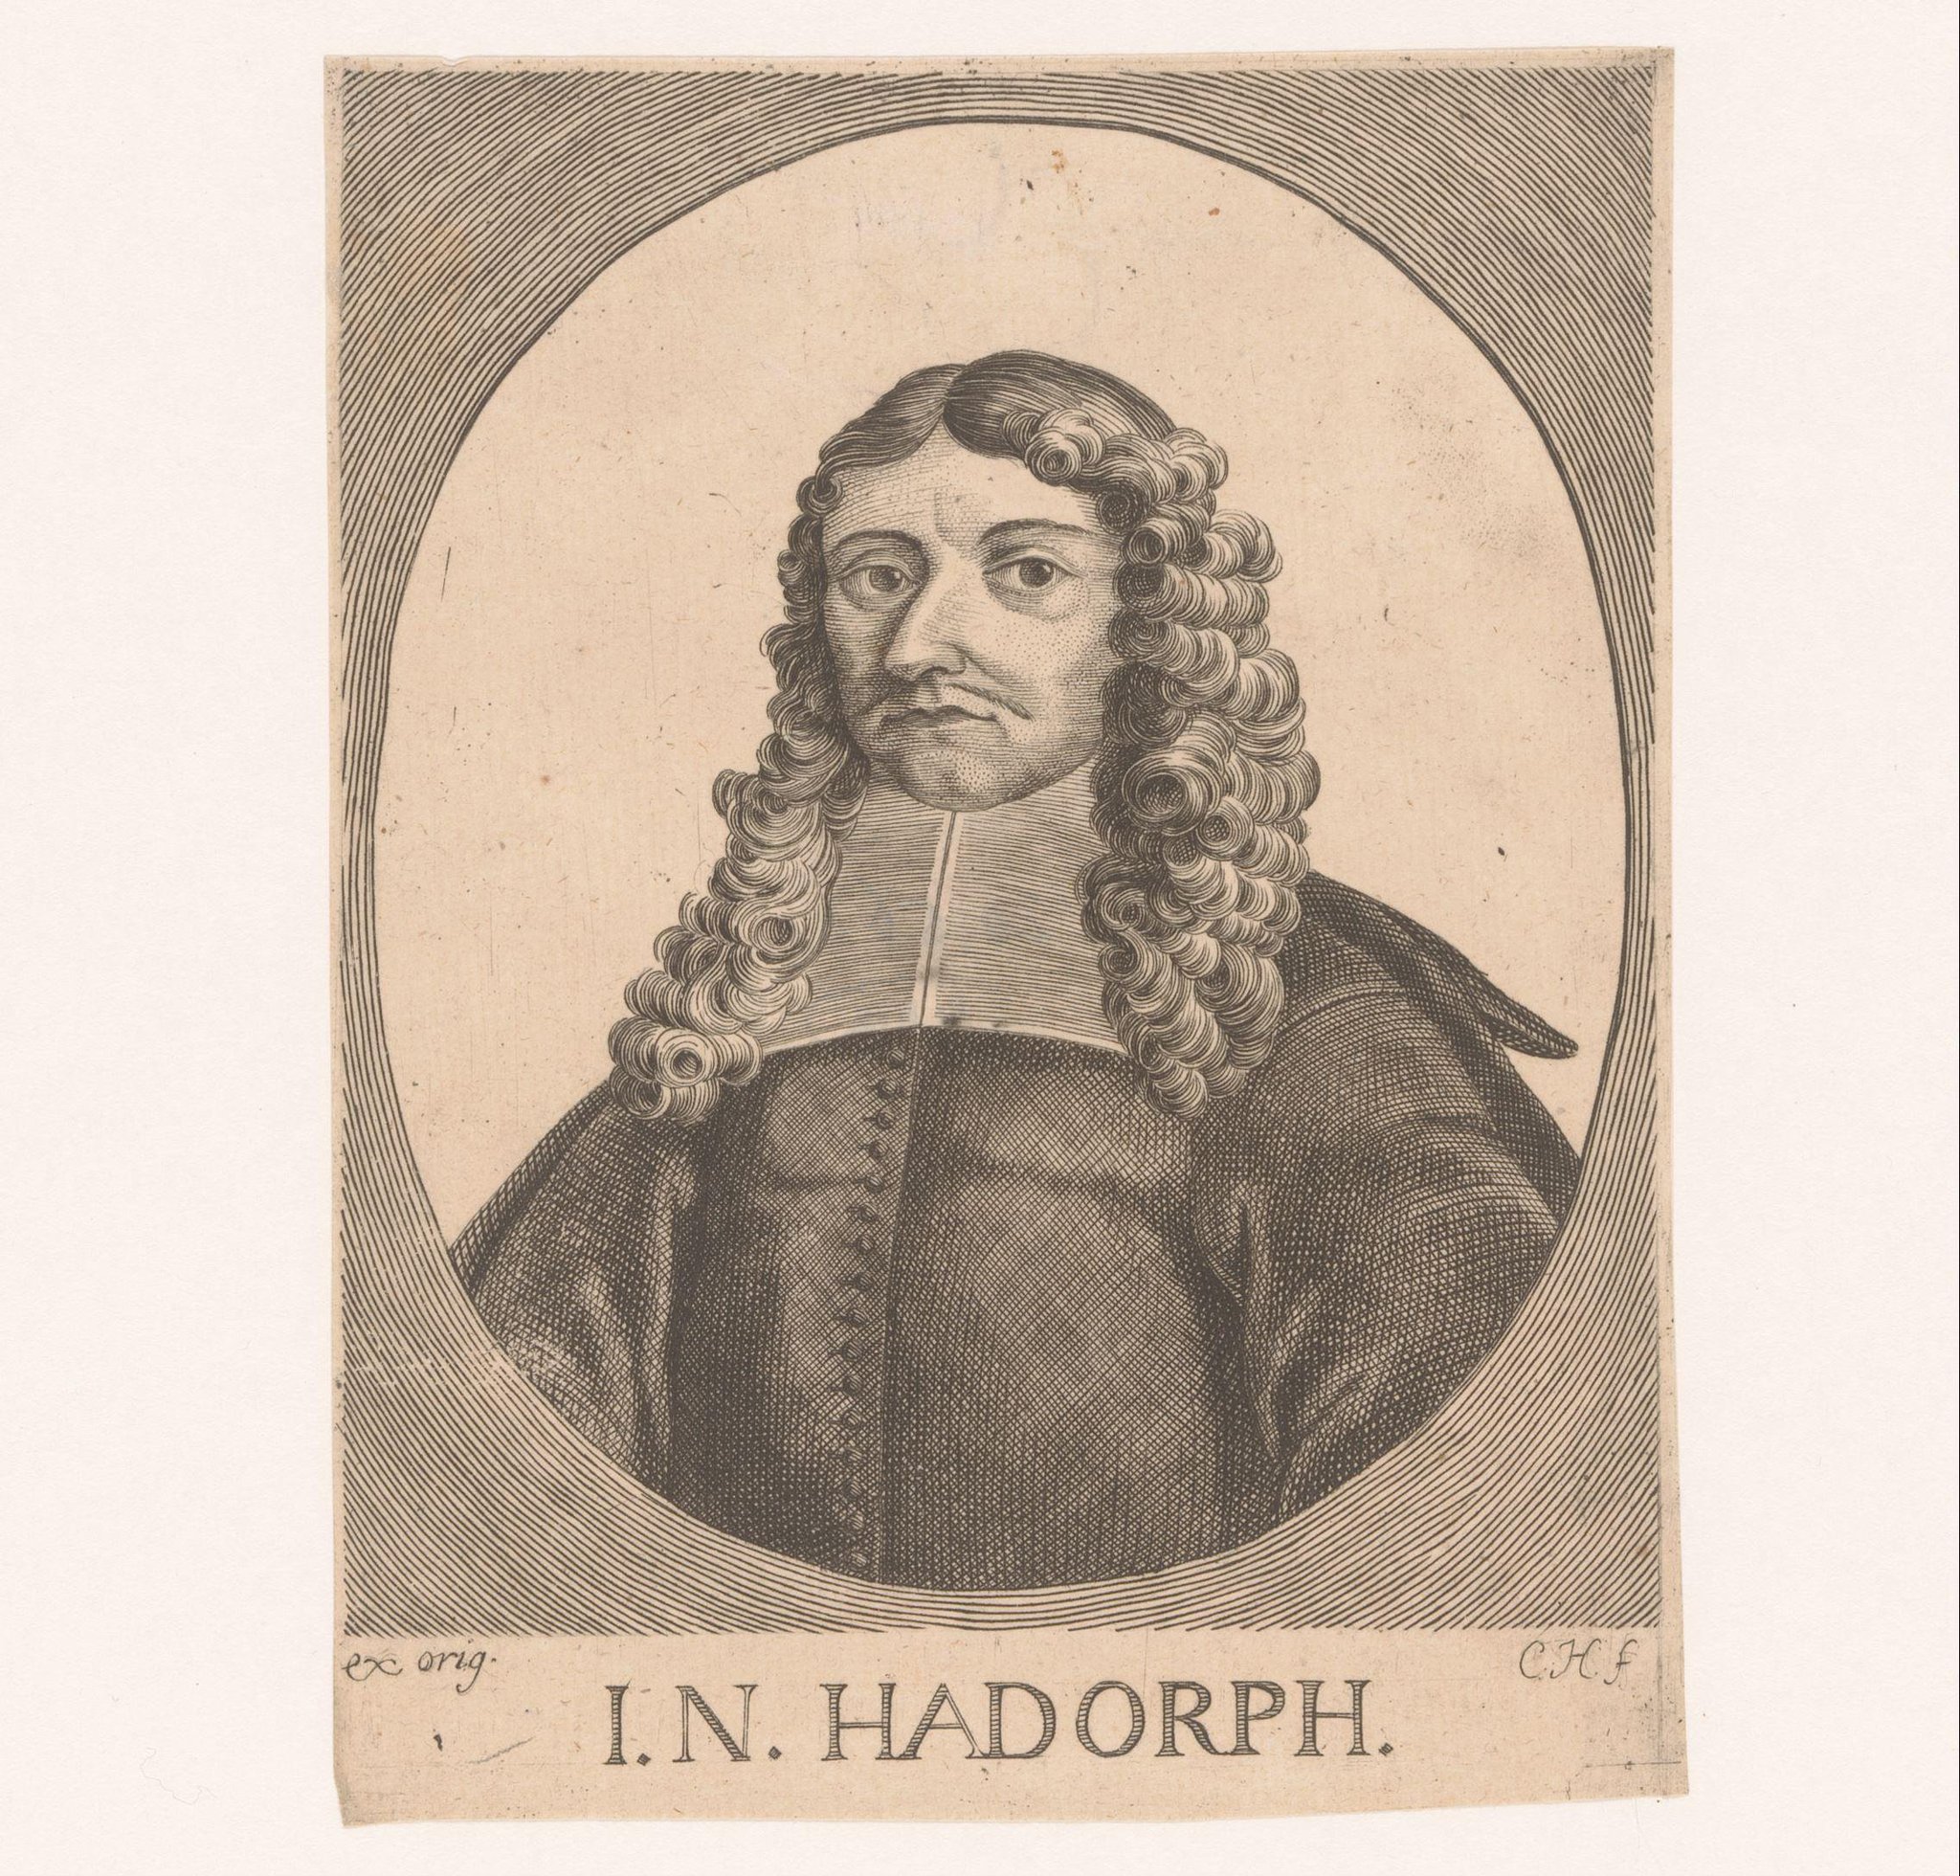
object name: print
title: Portret van Johan Hadorph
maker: monogrammist ch (18e eeuw)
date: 1700-1799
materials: paper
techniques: engraving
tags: historical persons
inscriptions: collector's mark: Lugt 2228